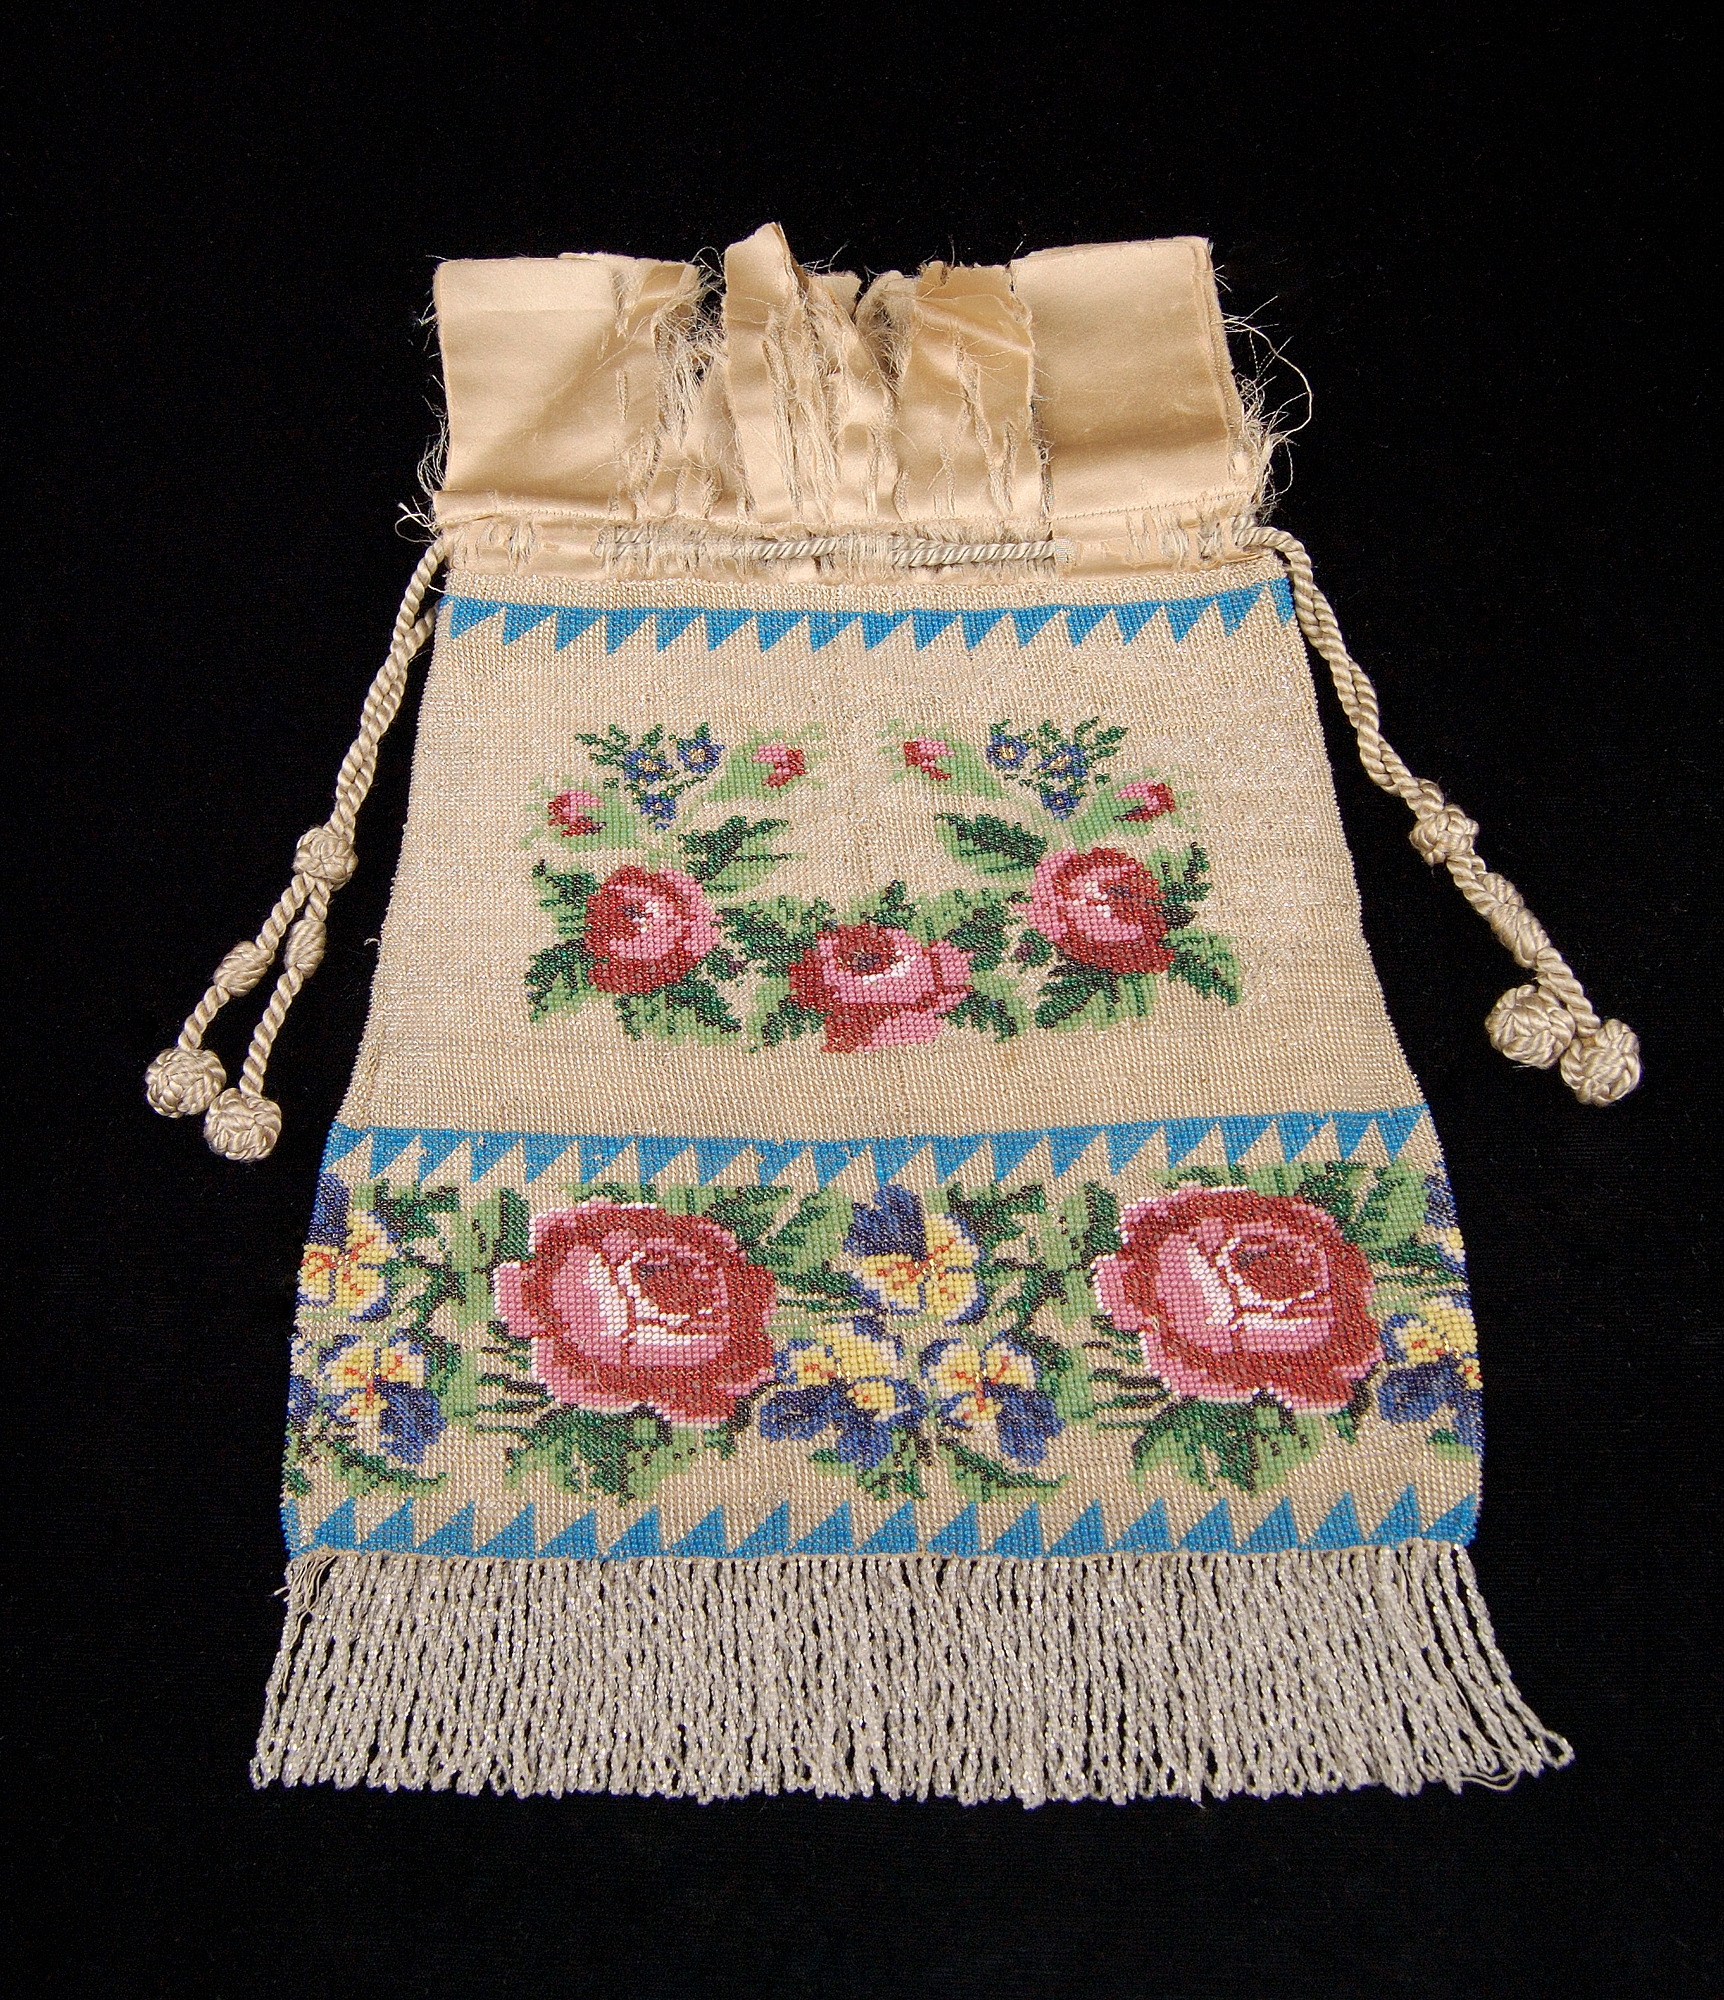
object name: pouch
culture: german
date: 1851-1875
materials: glass, silk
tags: roses